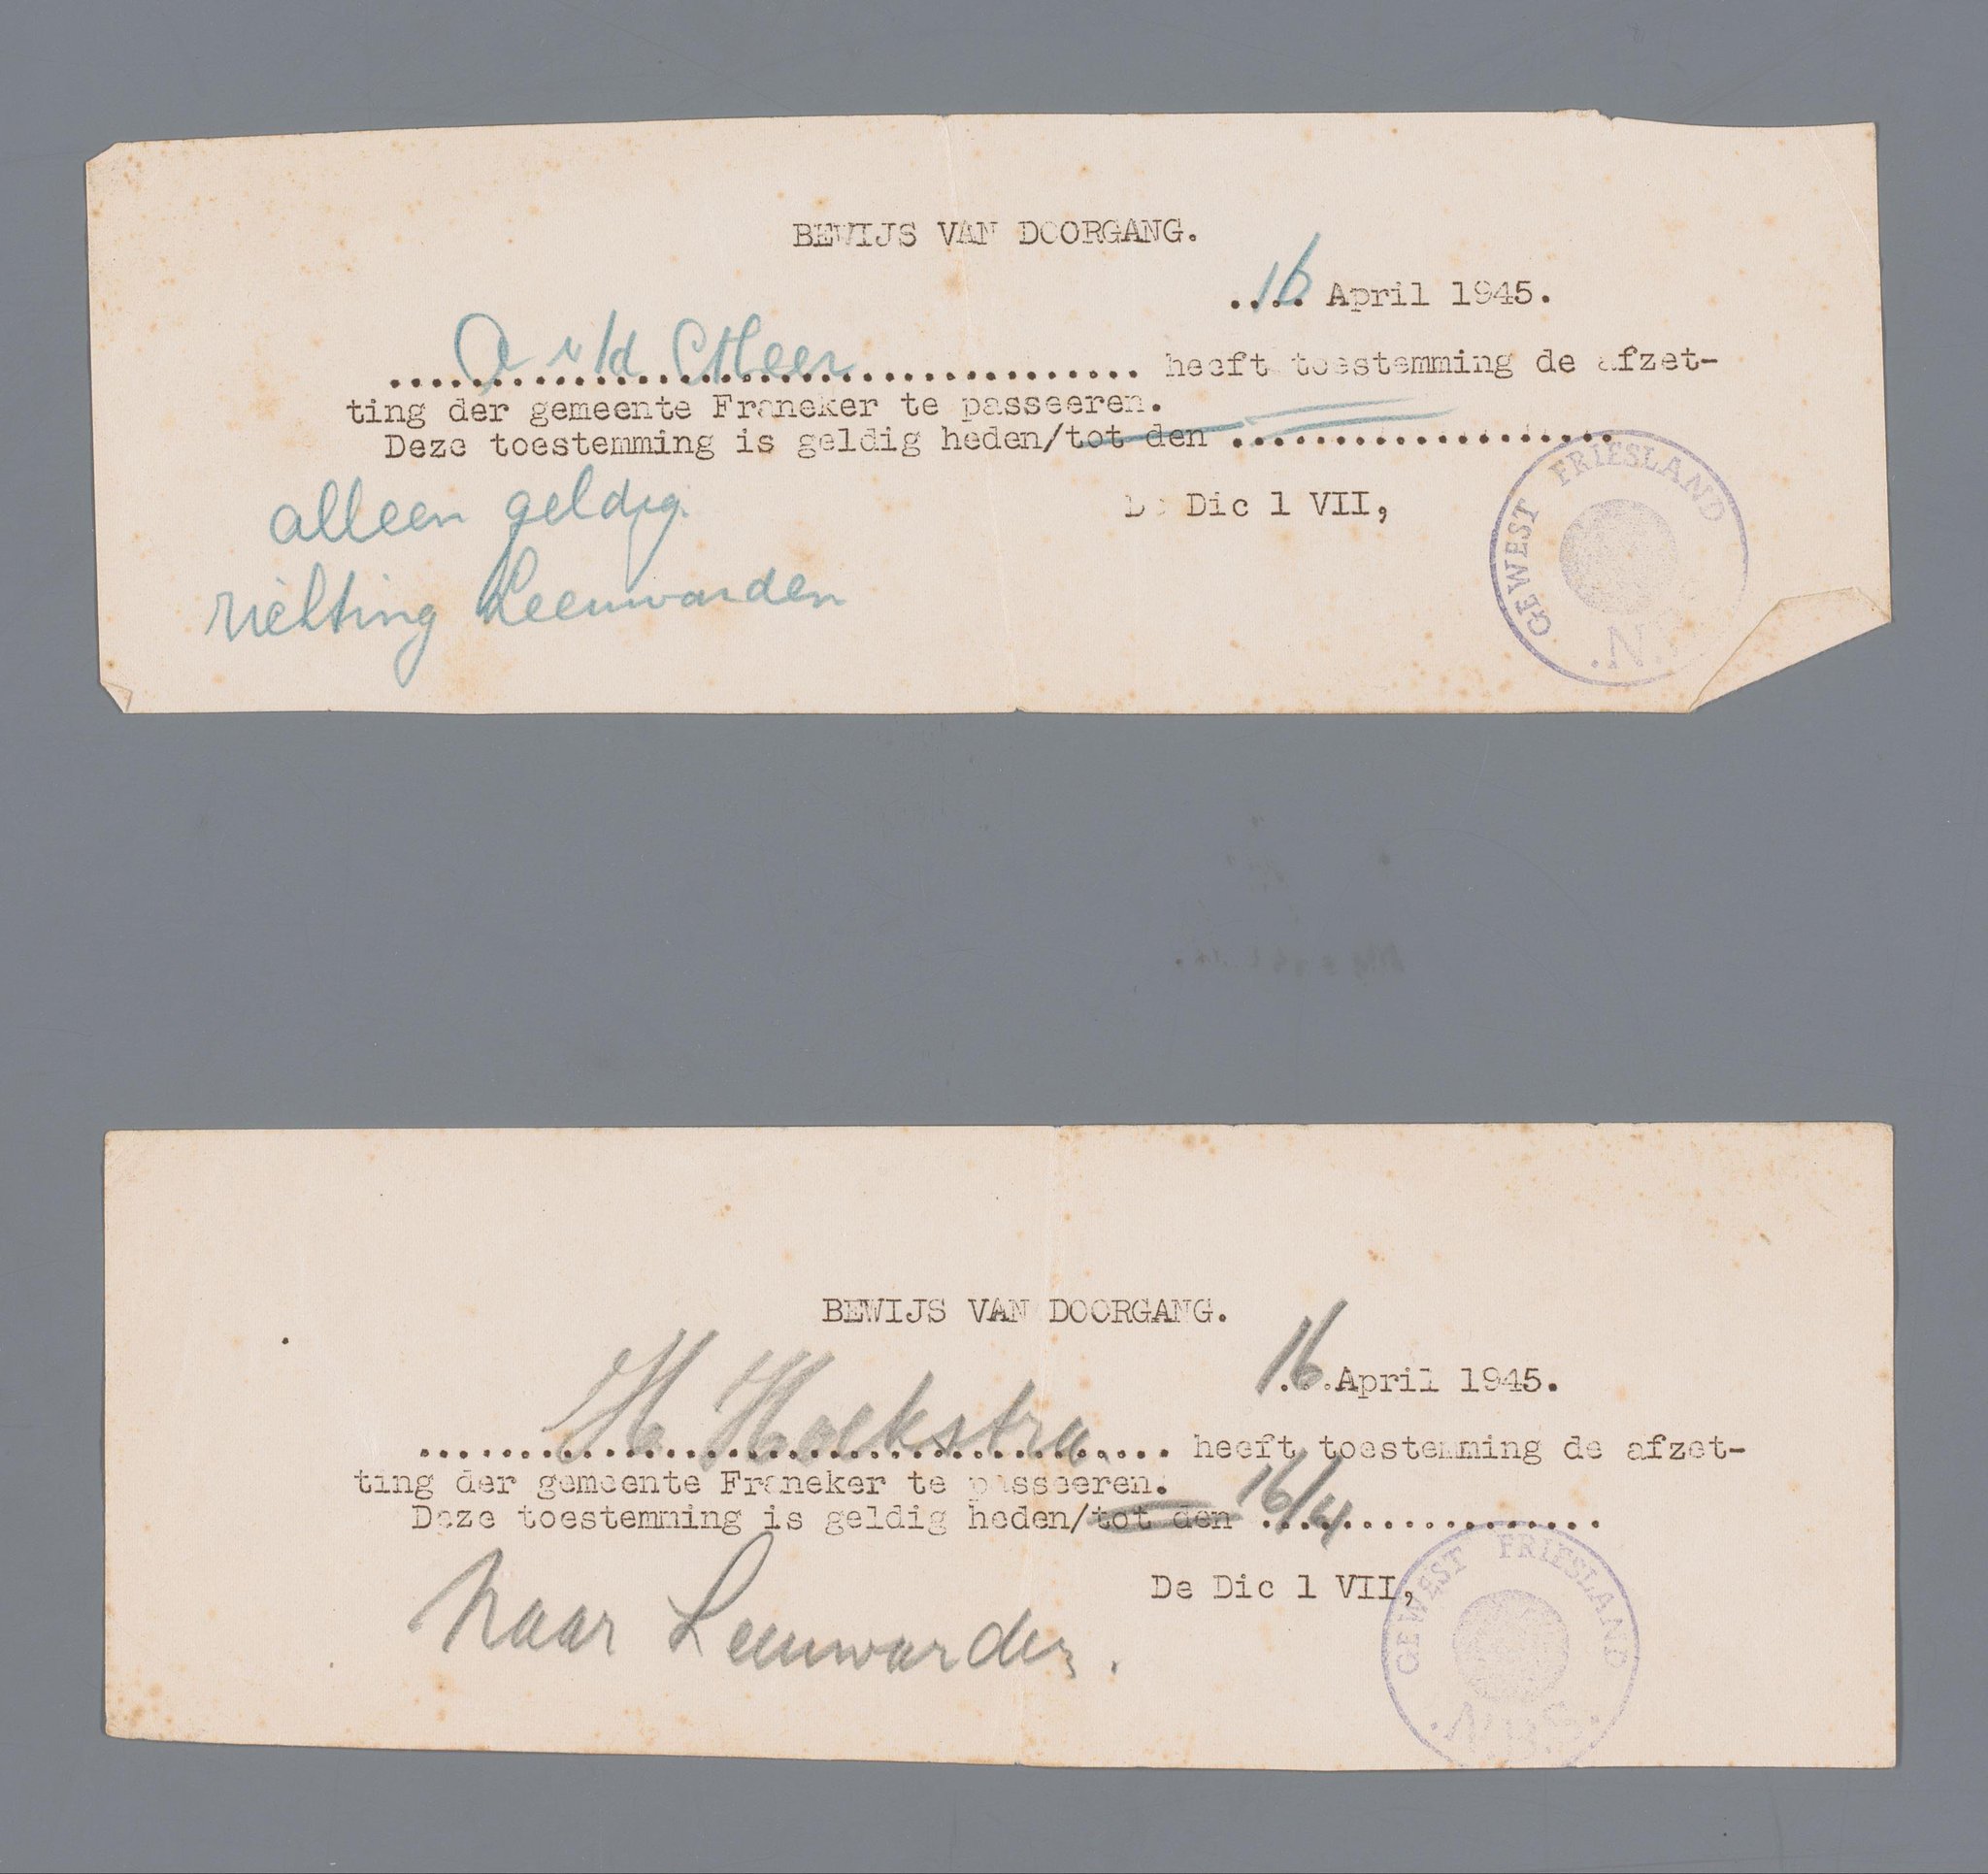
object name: document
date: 1945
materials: paper, pencil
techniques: mimeography, writing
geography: franeker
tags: netherlands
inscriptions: date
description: Document, bewijs van doorgang. Langwerpig, met potlood ingevuld stencil, waarin A. v/d Meer toestemming wordt verleend Franeker in de richting van Leeuwarden te verlaten. Gemerkt; stempel: 'N.B.S. Gewest Friesland'.